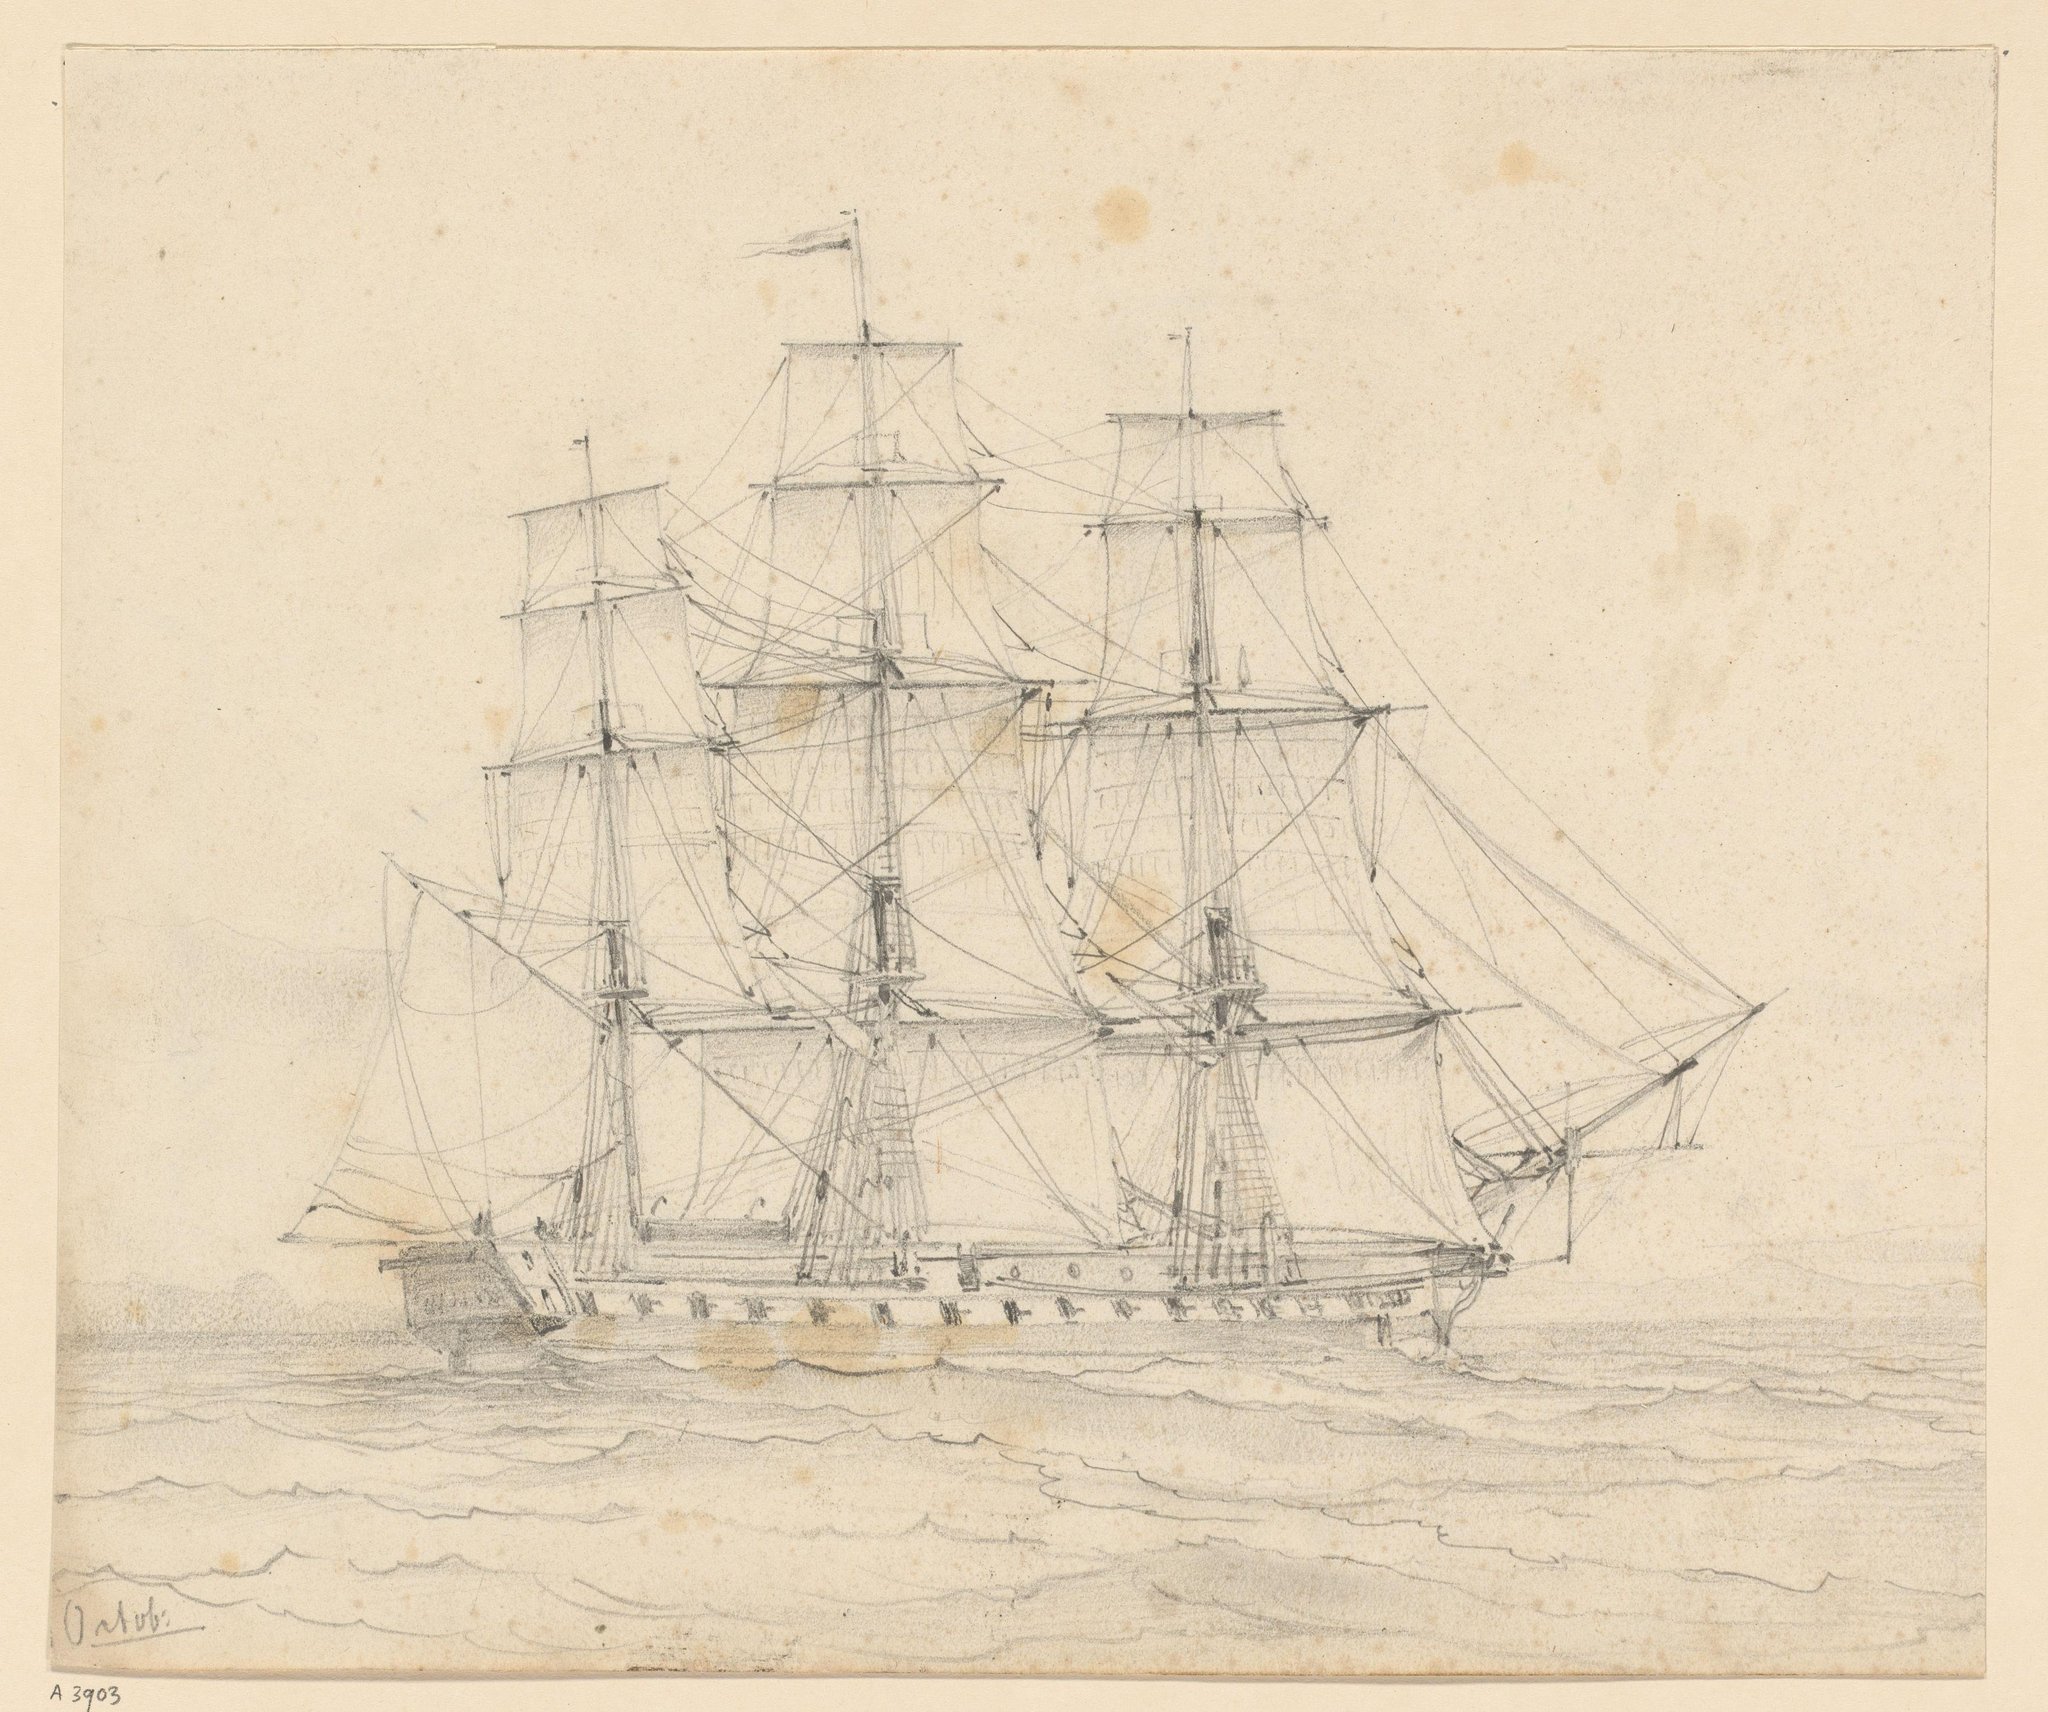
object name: drawing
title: Driemaster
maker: willem anthonie van deventer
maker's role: draughtsman, painter, print maker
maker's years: 1824-1893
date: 1834-1893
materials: paper, pencil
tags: sailing-ship, sailing-boat